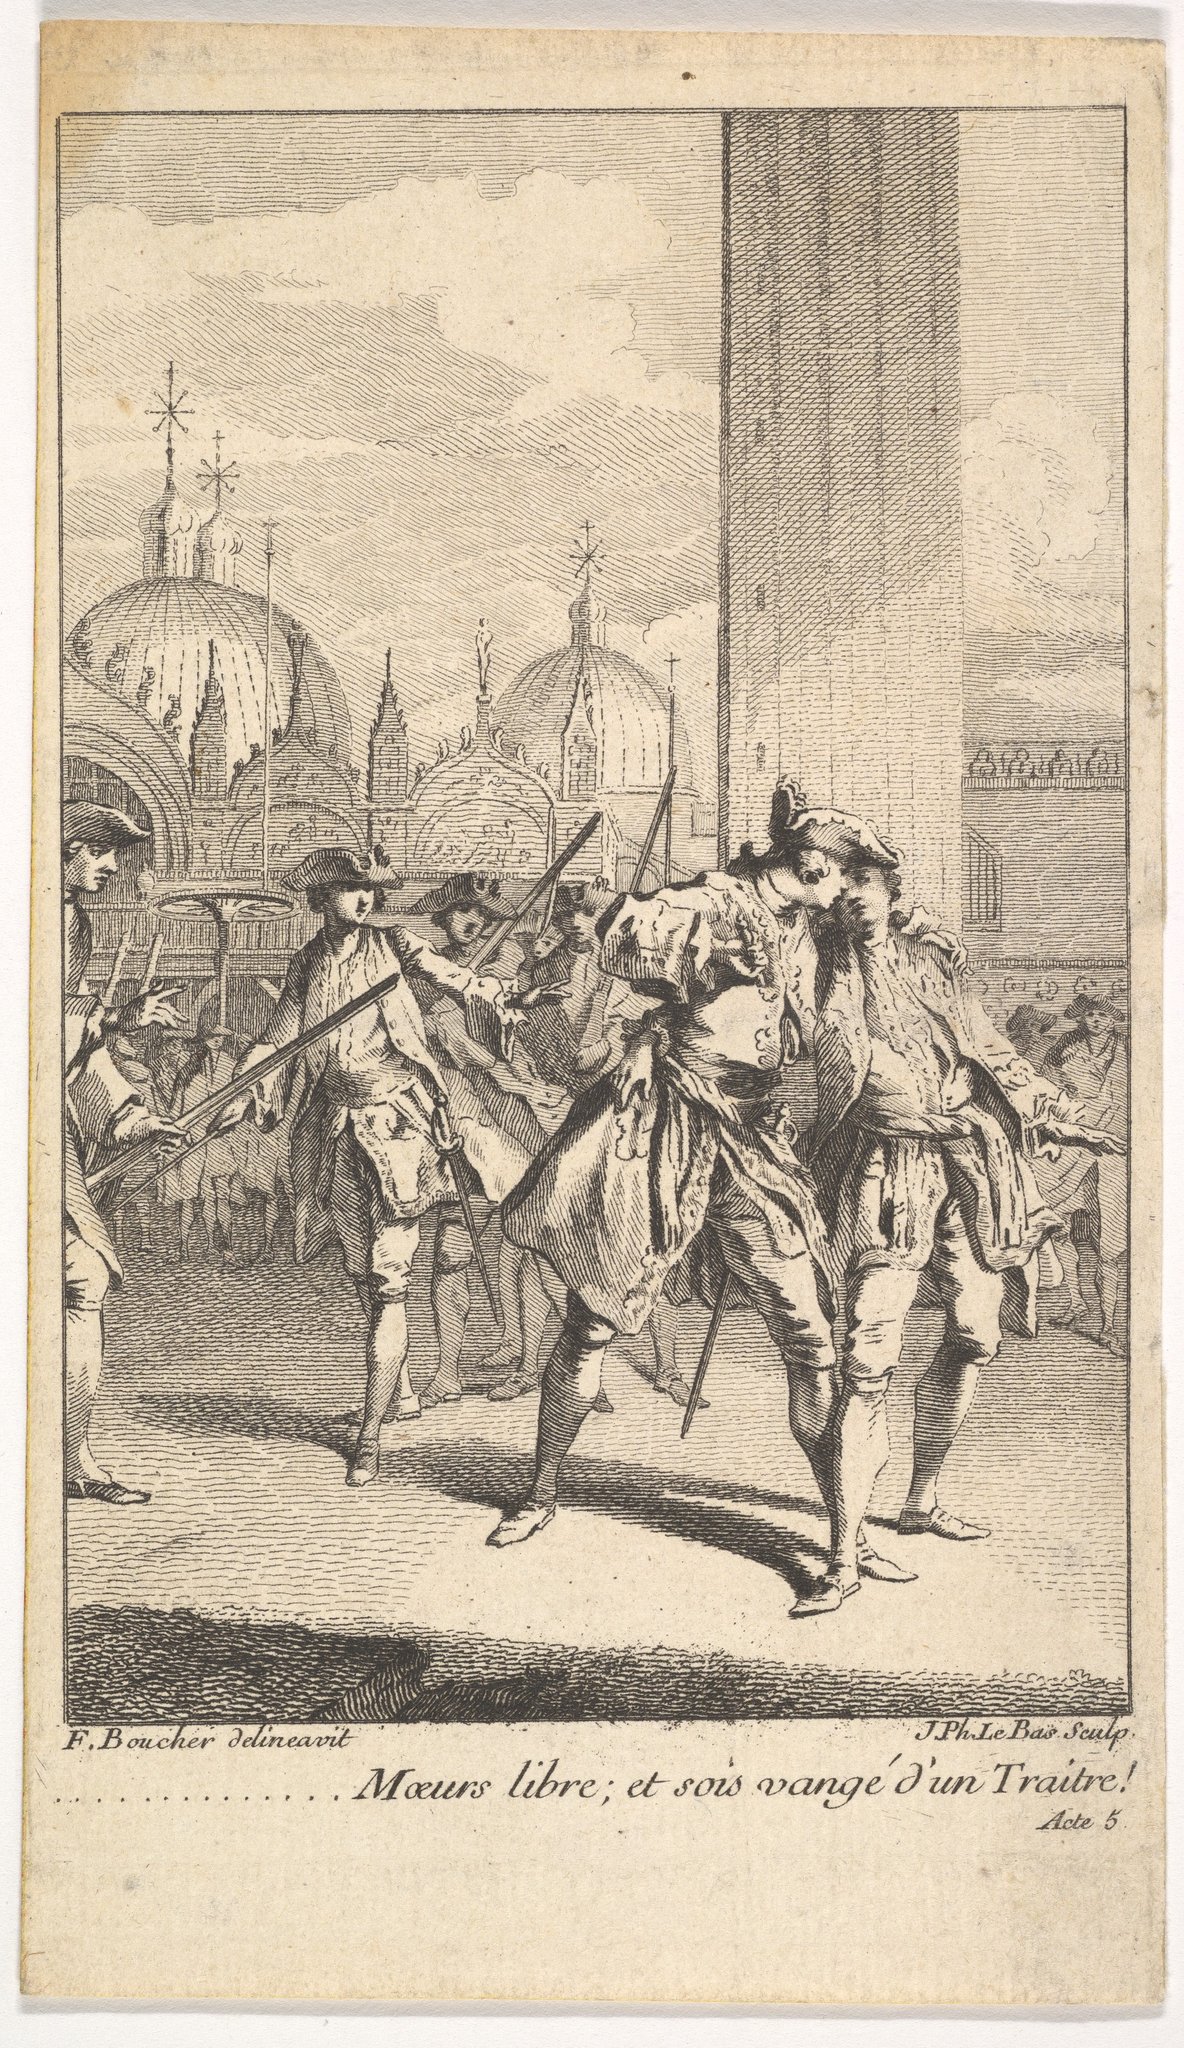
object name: print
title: Frontispiece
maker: jacques philippe le bas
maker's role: artist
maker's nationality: french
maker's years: 1707-1783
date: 1707-1783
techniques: engraving, etching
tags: men